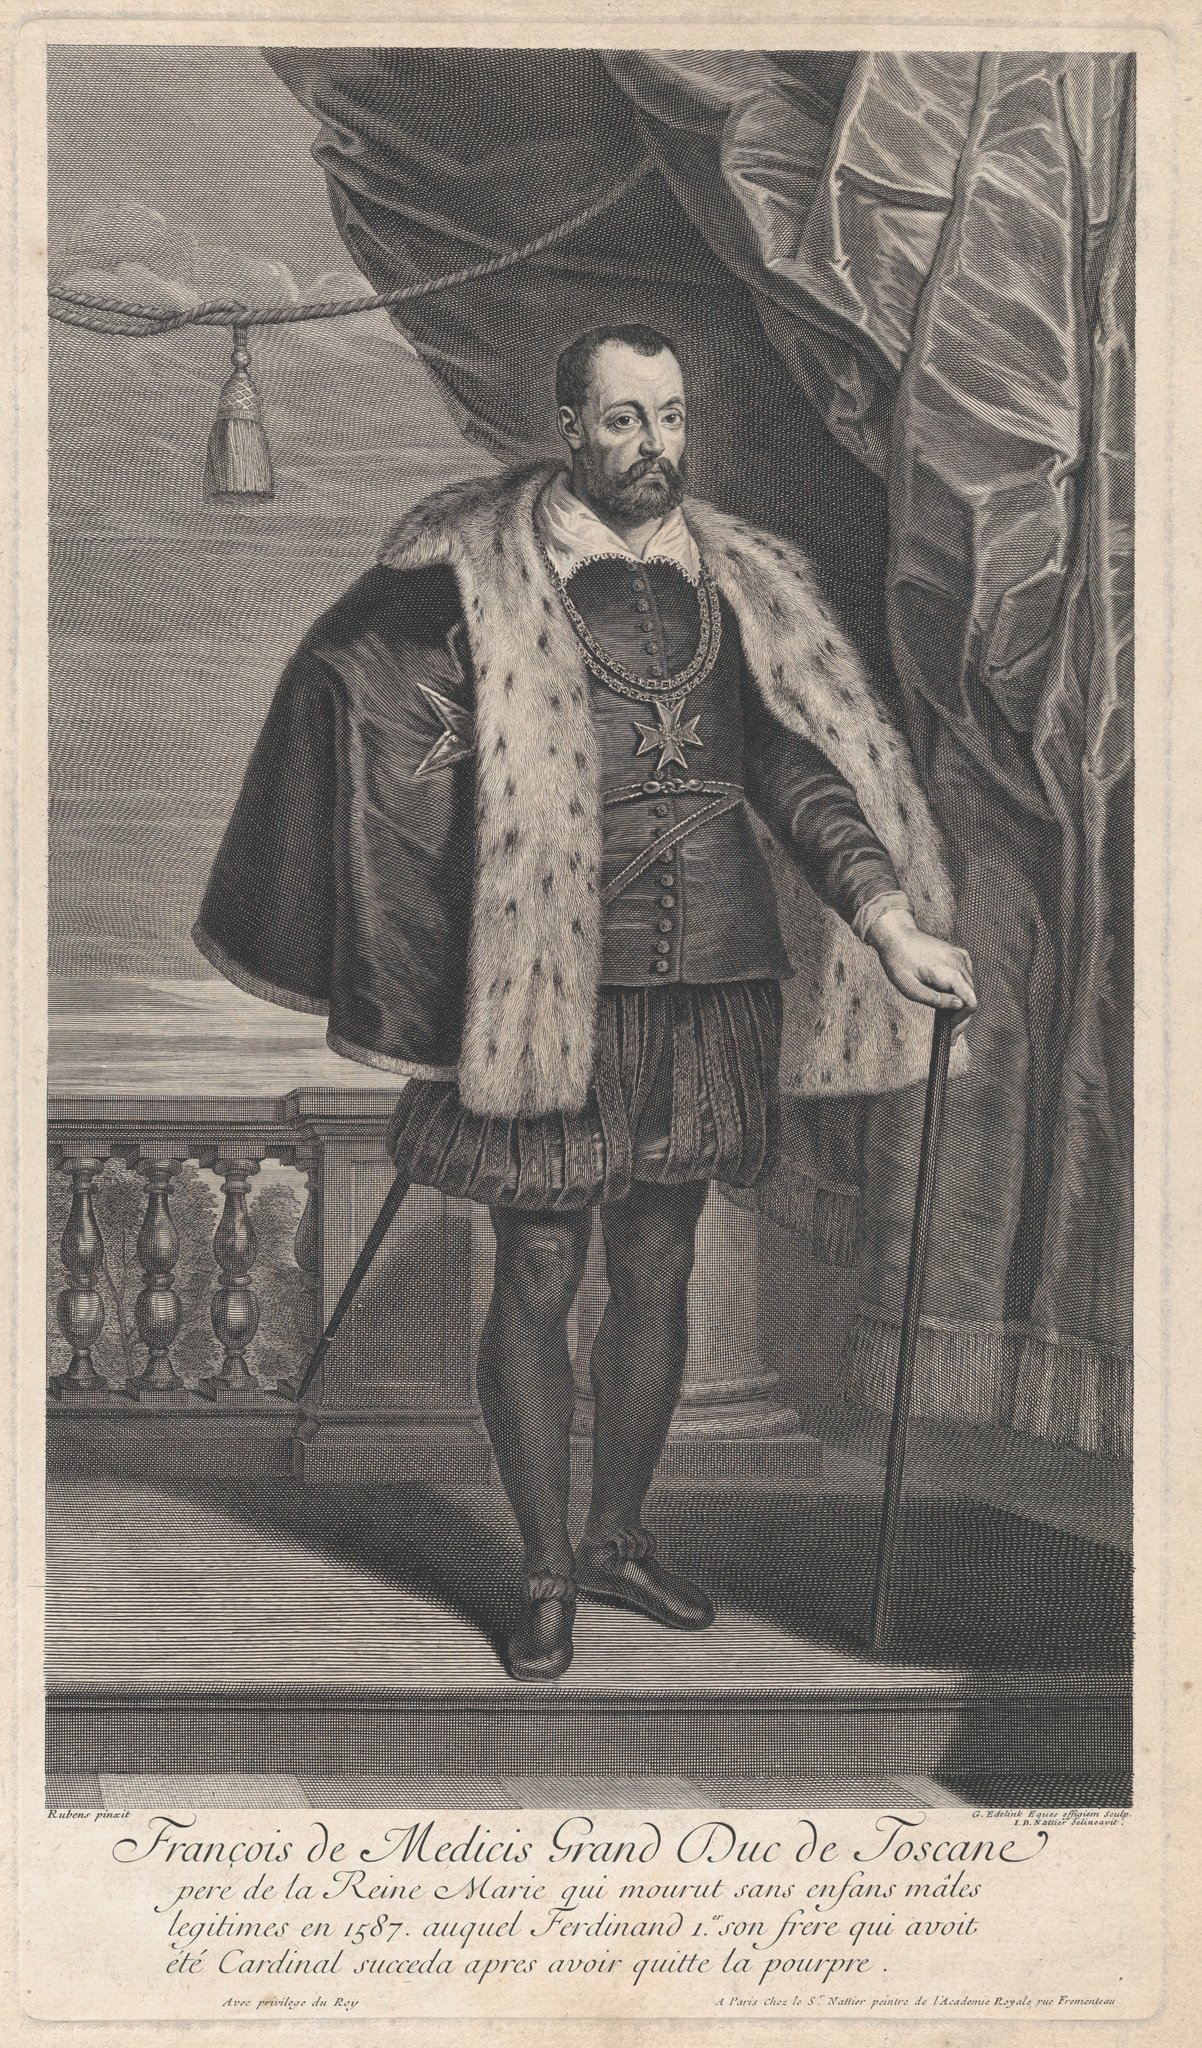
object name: print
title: Portrait of Francesco I de' Medici, Grand Duke of Tuscany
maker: gerard edelinck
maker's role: artist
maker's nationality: dutch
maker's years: 1640-1707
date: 1707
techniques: engraving, etching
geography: paris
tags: men,portraits